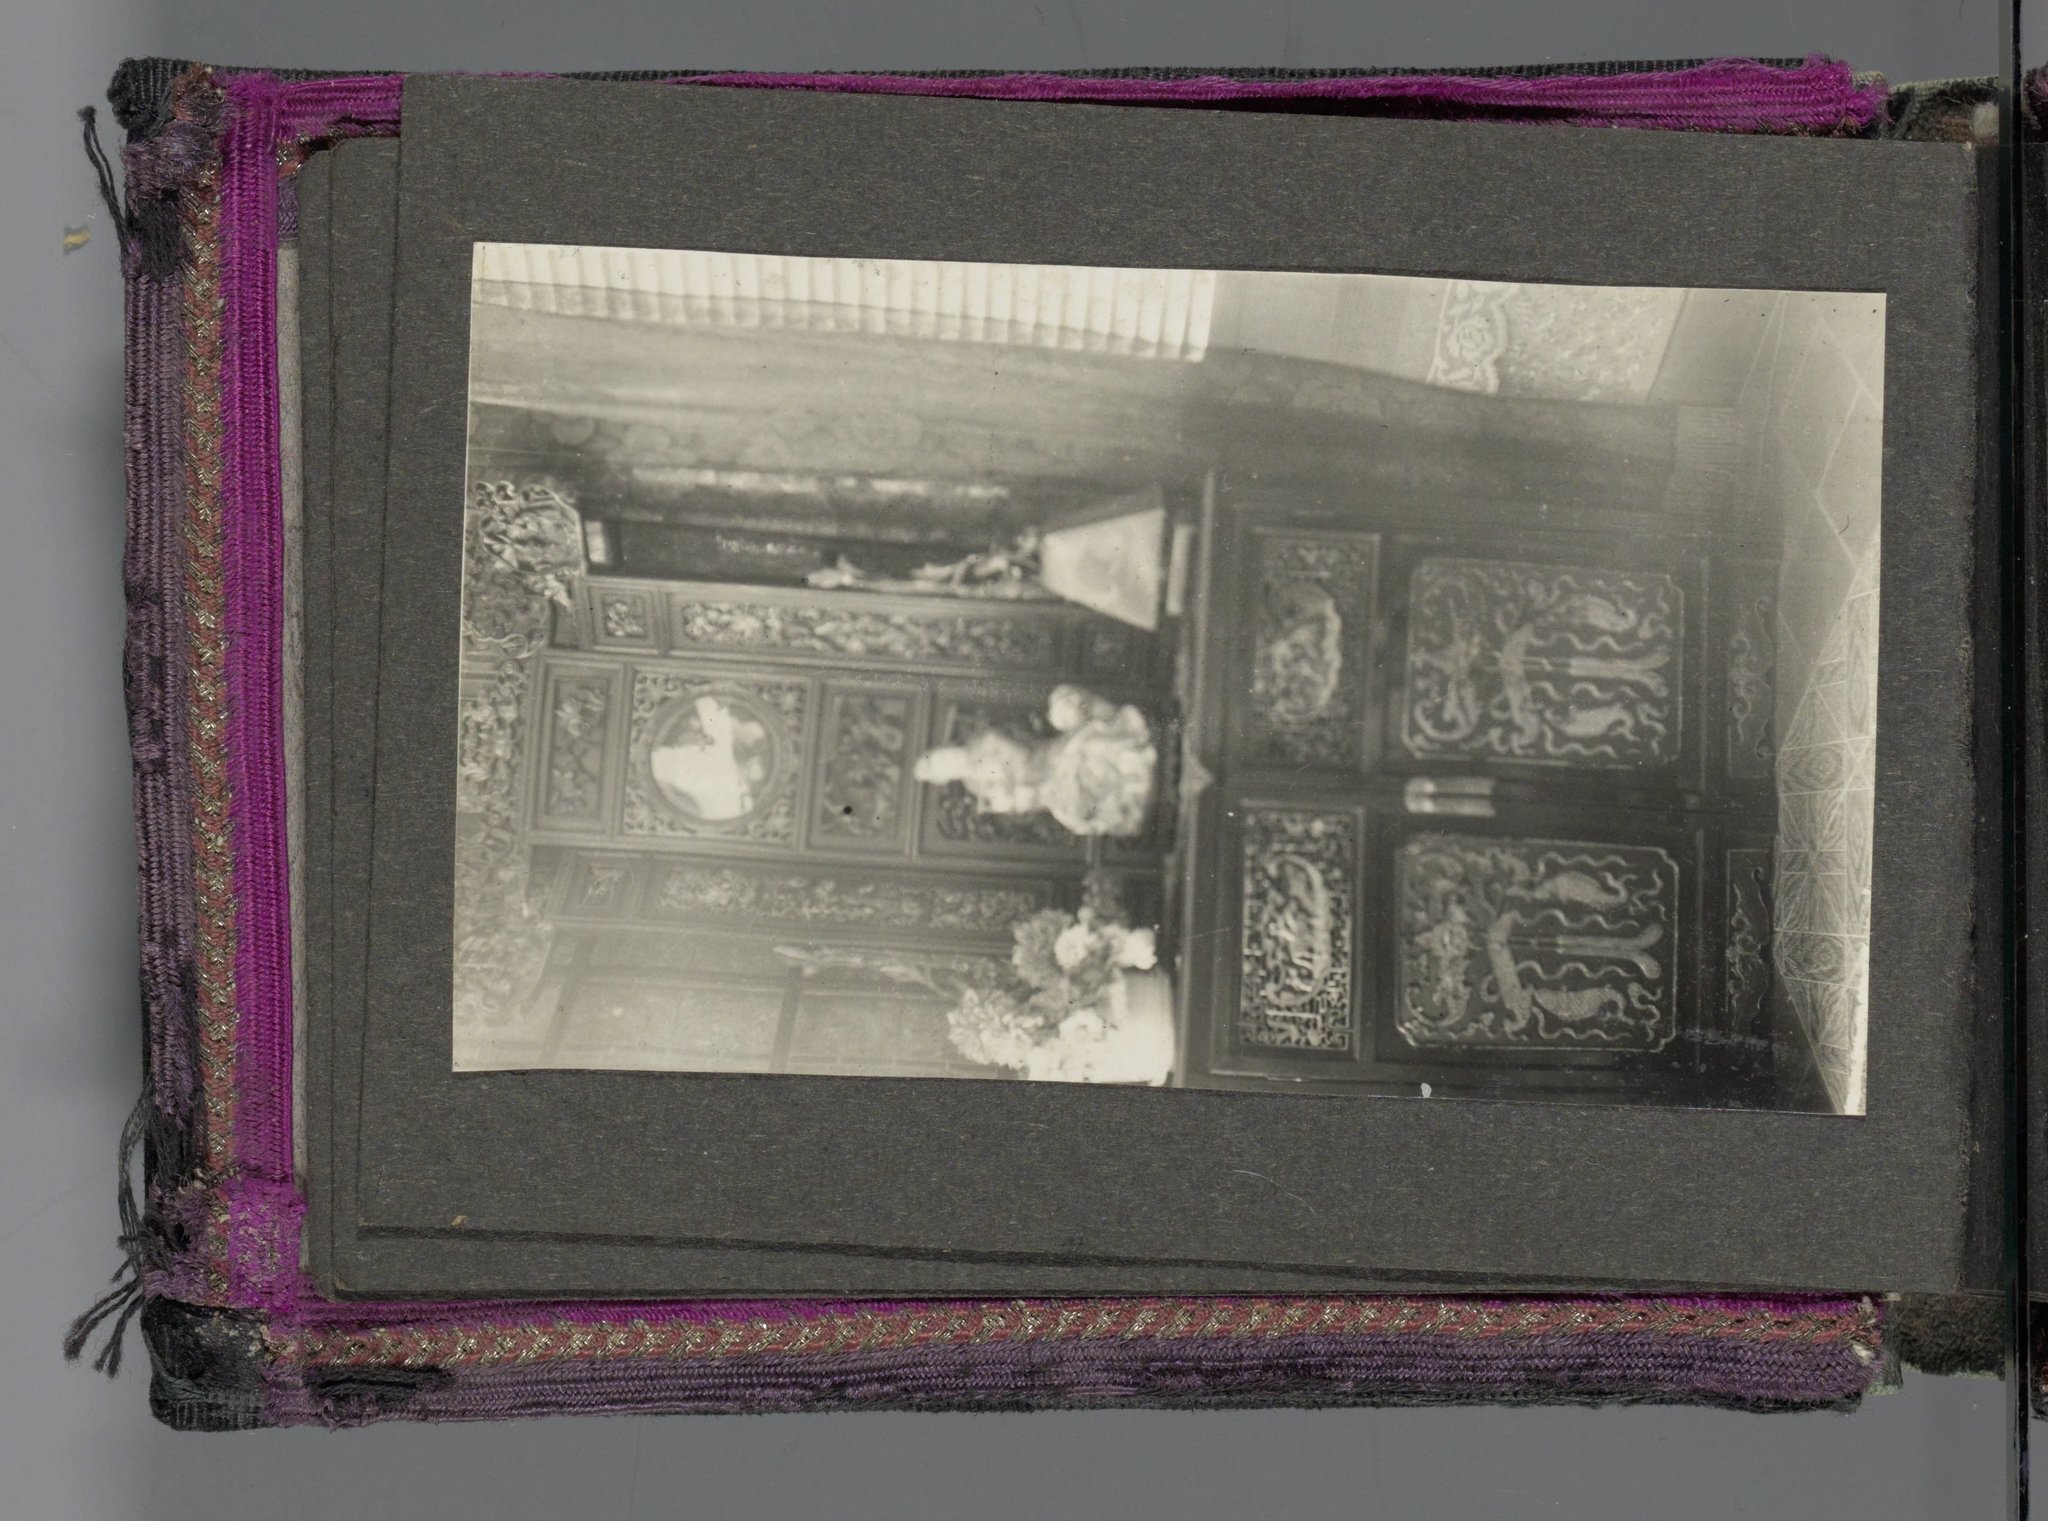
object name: photograph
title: Chinese beeldjes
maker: elsa silberstein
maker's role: amateurfotograaf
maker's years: -2006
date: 1935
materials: photographic support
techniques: gelatin silver print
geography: bandung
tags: elsa silberstein, interior of the house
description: Enkele Chinese beeldjes. In het woonhuis van Elsa Silberstein en haar man, thesaurier-generaal in Bandung in 1935. Schilderijtjes aan de muur. Onderdeel van het fotoalbum met zwart-wit foto's van het interieur van het huis van de familie Silberstein in Bandung in Nederlands-Indië.